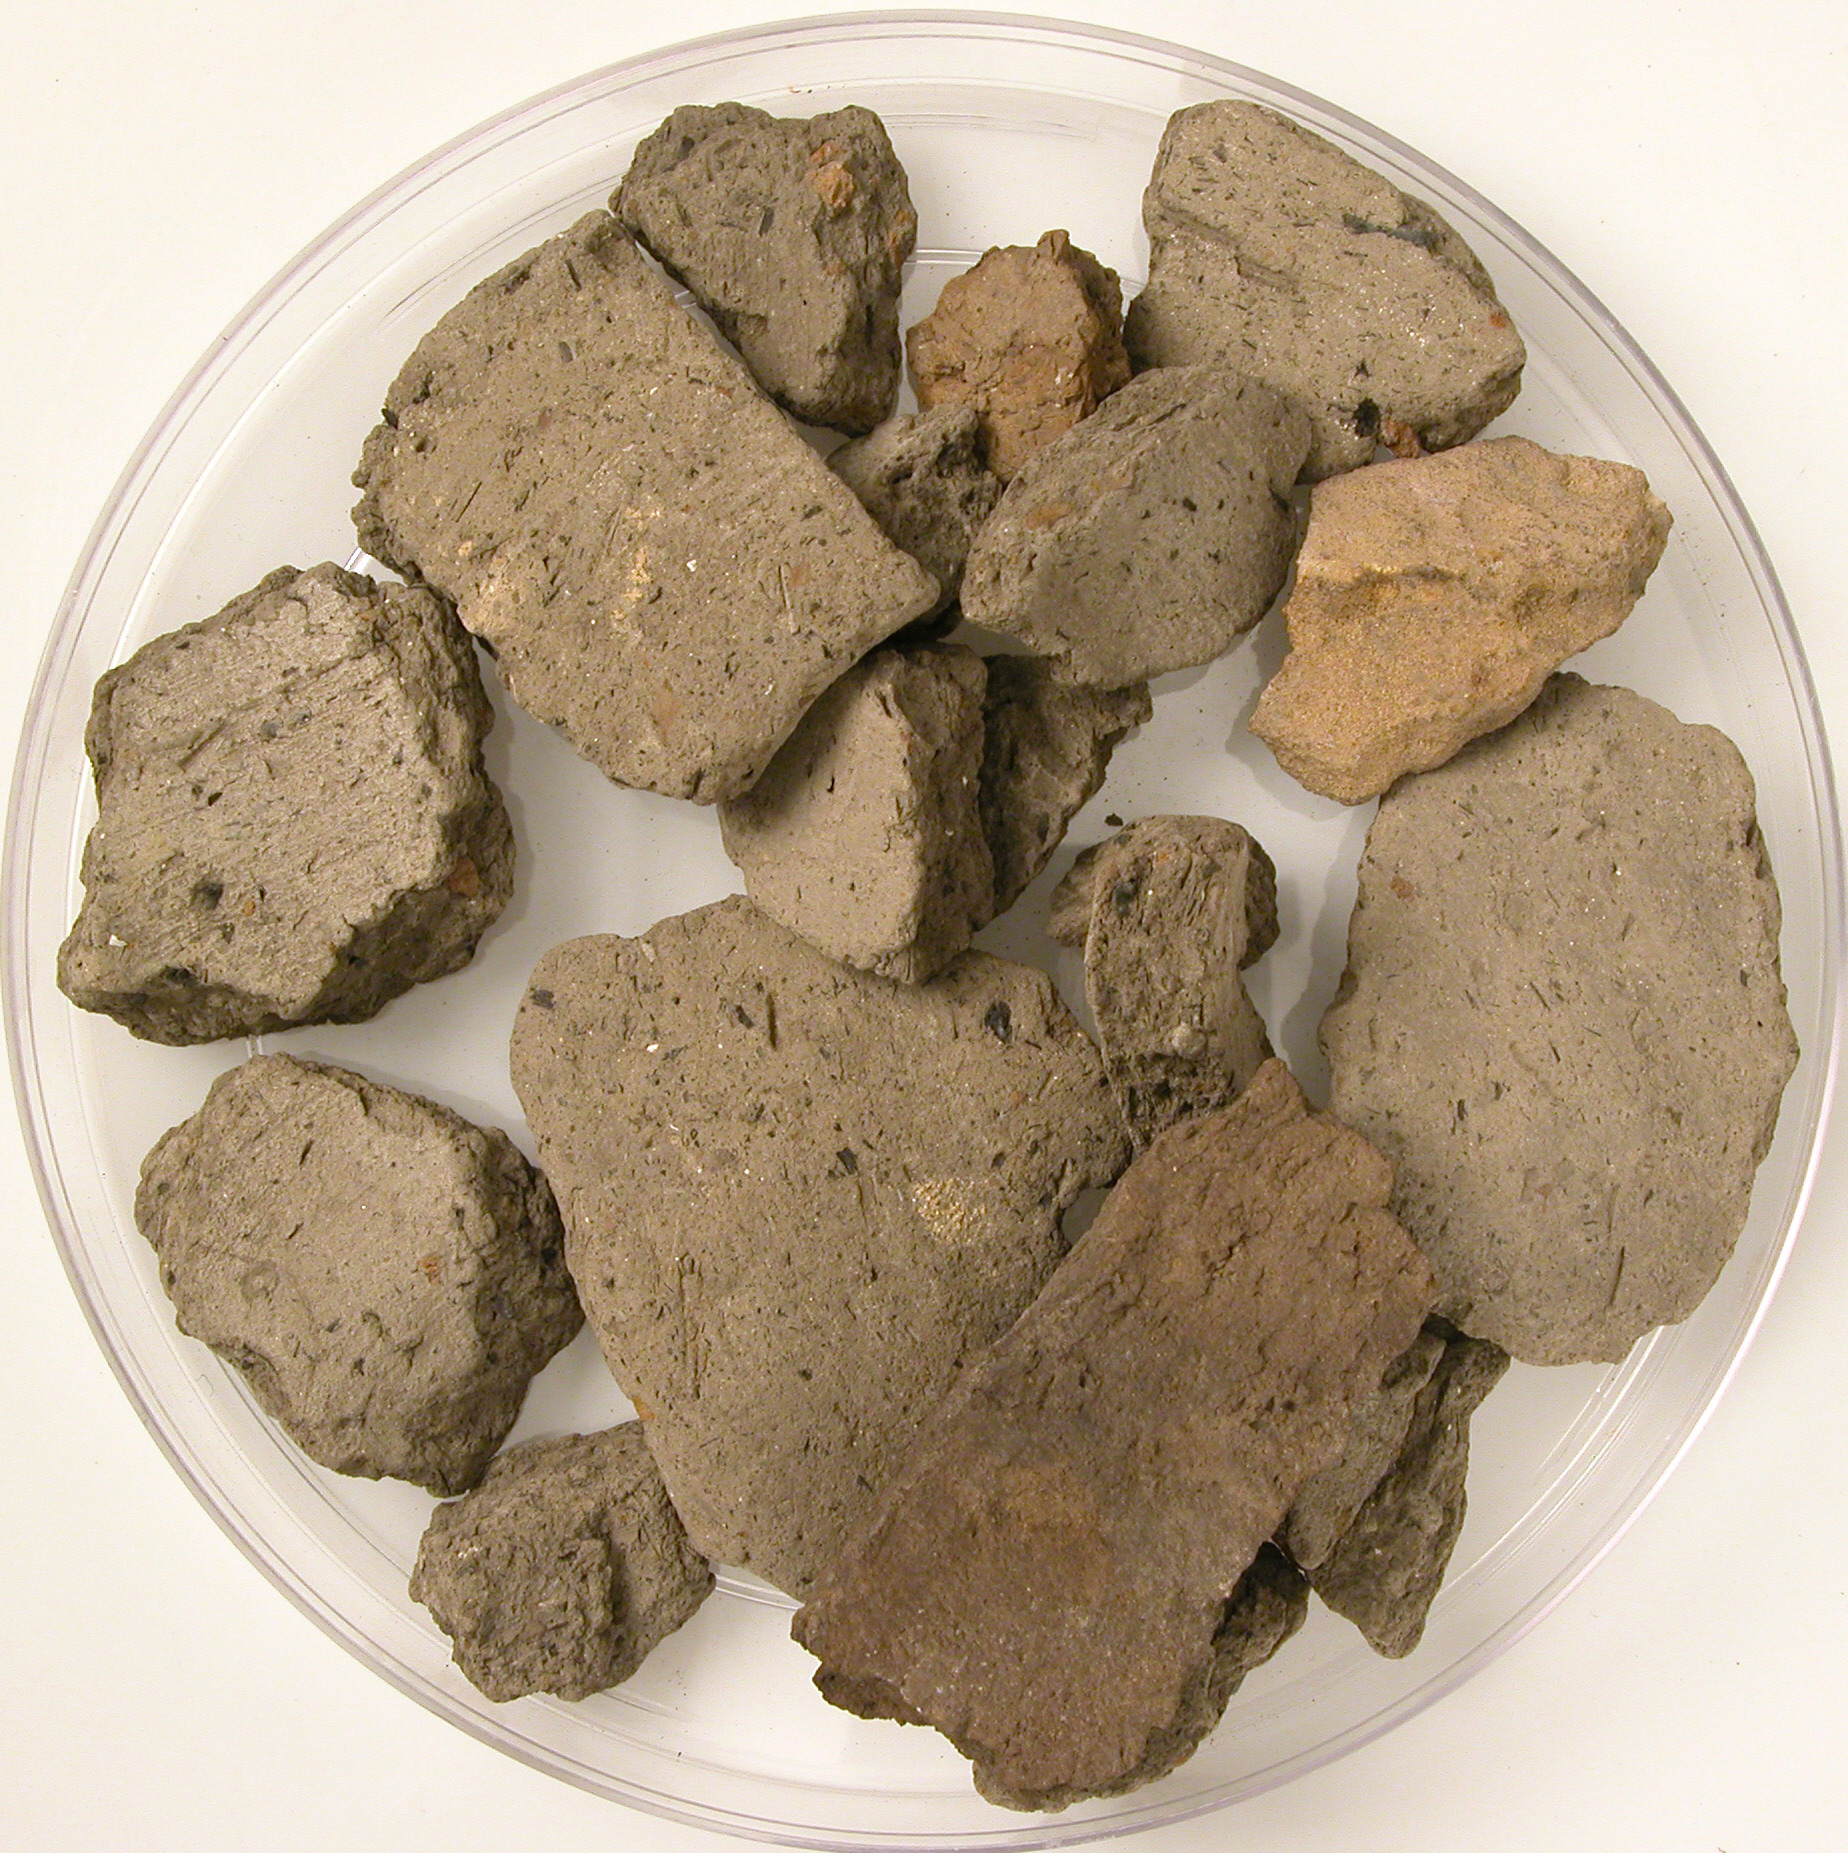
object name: fragment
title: Fragments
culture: coptic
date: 301-700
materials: stone, terracotta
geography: egypt